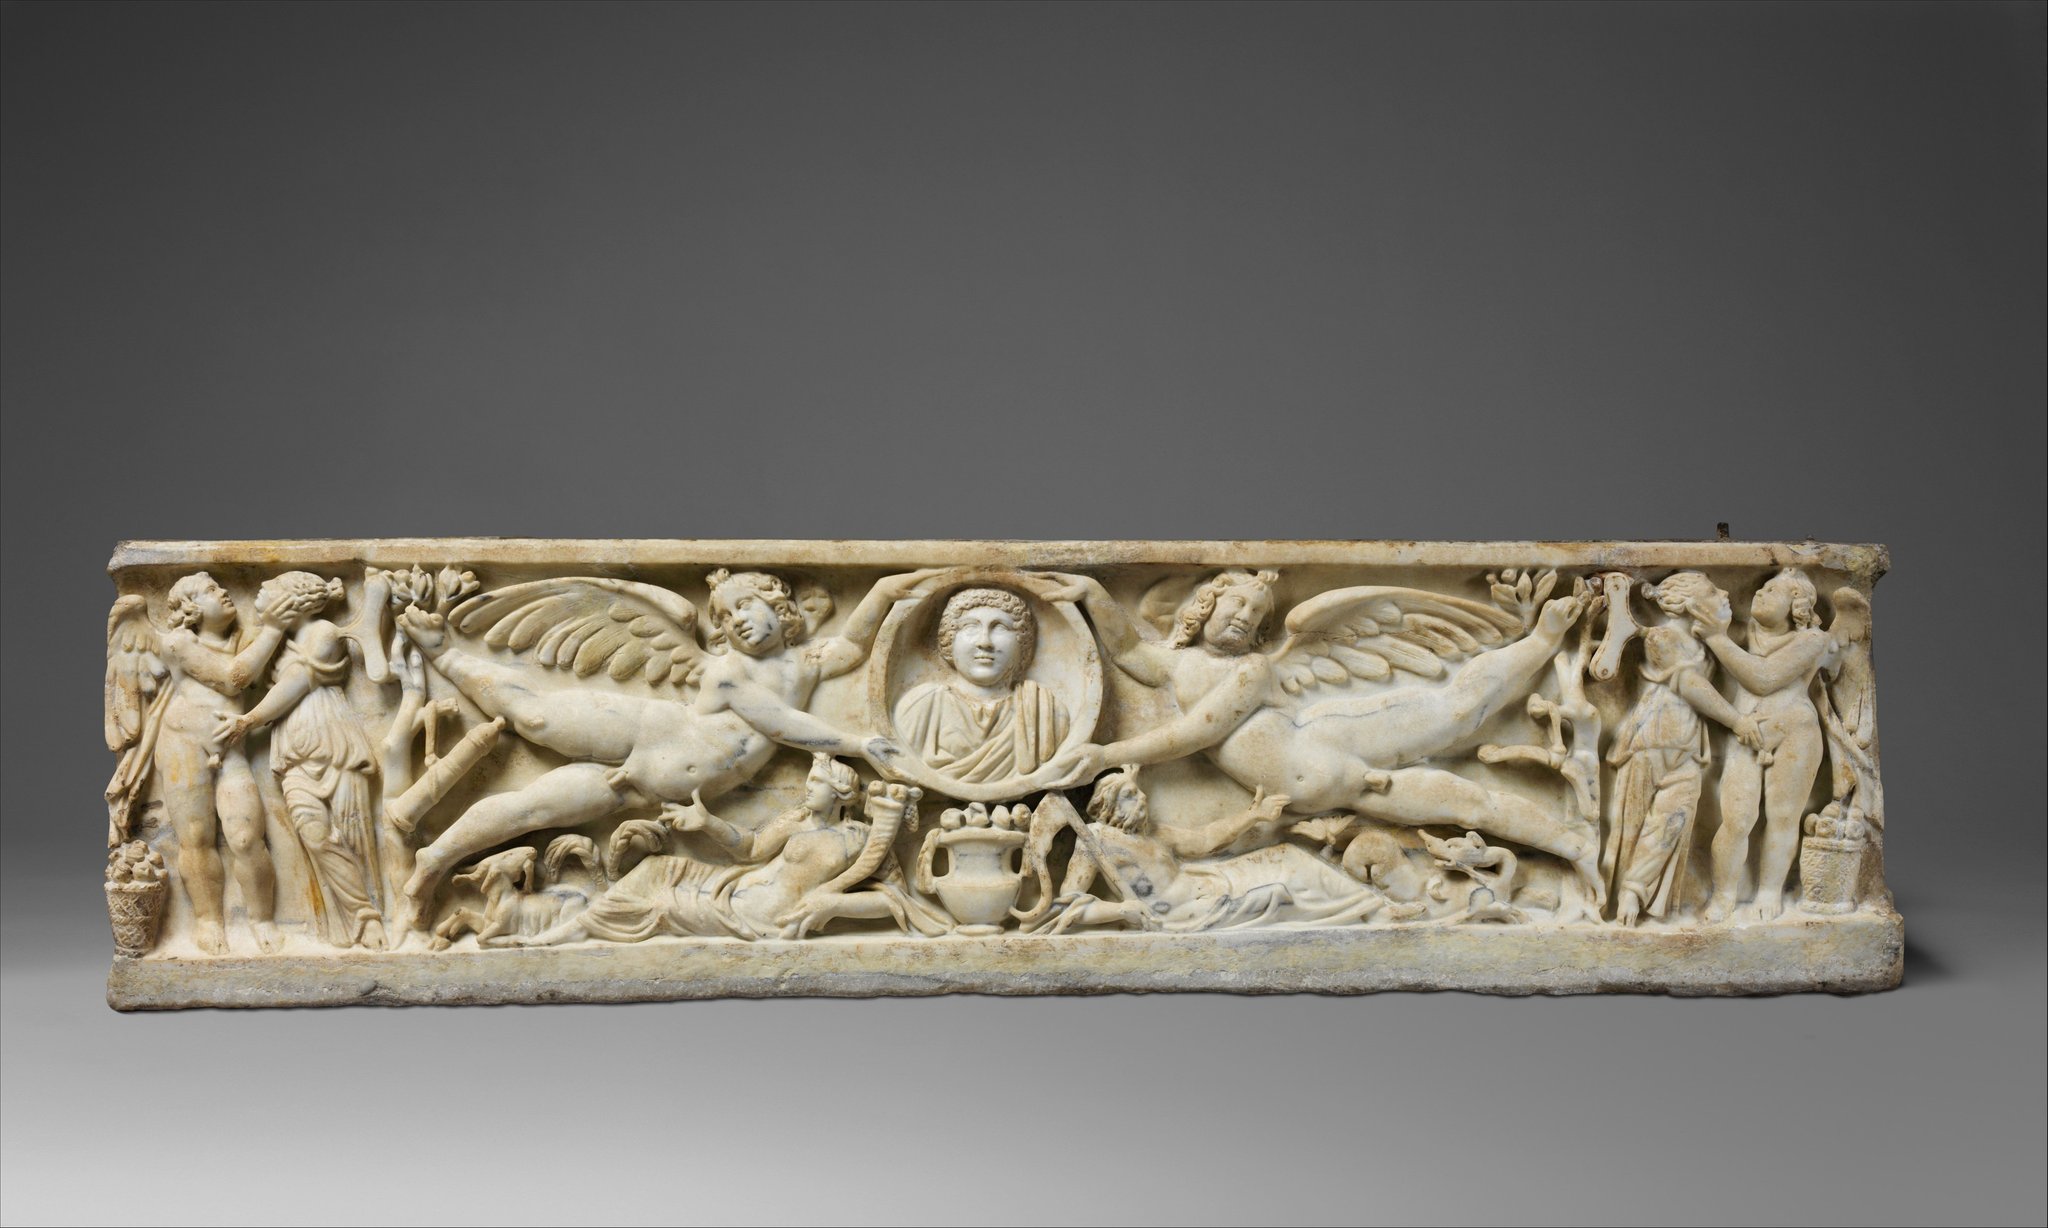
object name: sarcophagus with portrait medallion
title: Marble sarcophagus with flying erotes holding a clipeus portrait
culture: roman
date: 190-200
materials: marble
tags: portraits,eros,psyche,sarcophagus